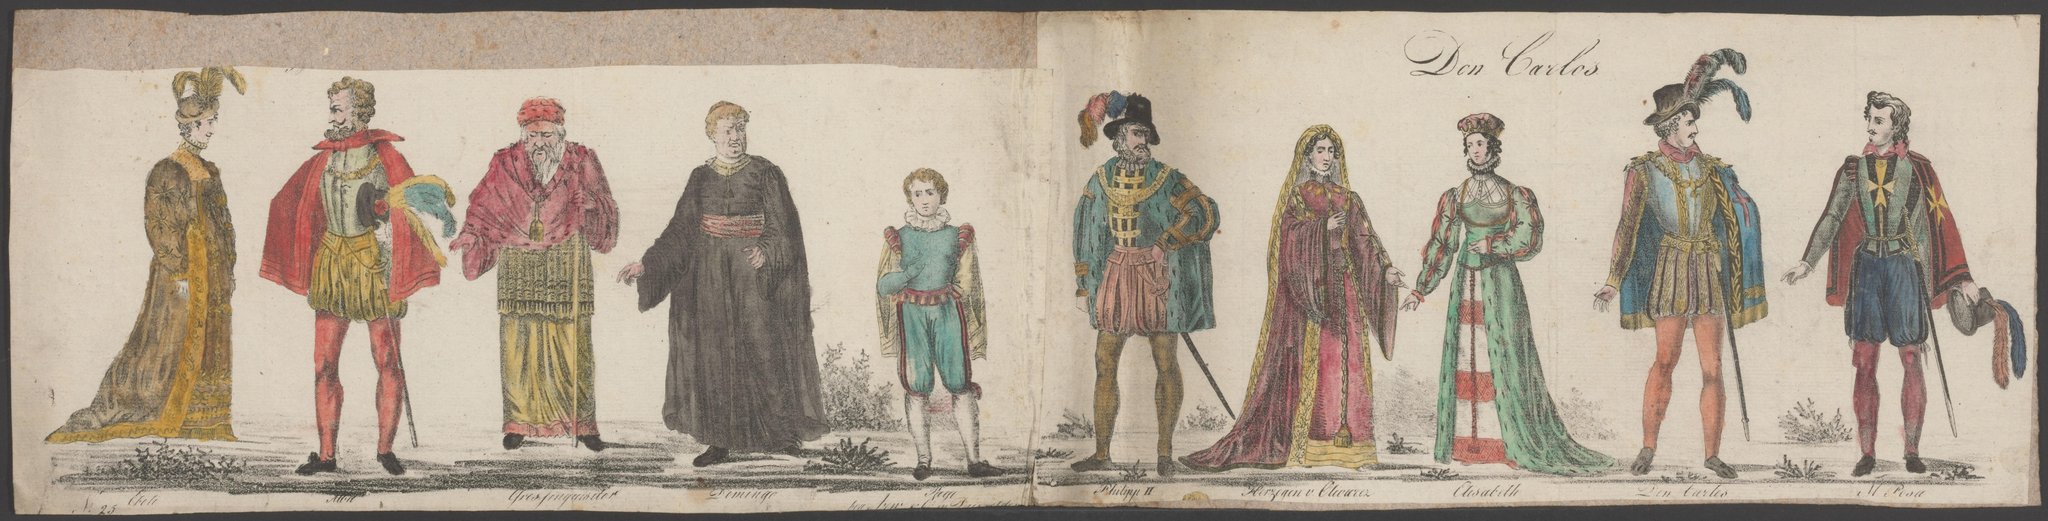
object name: print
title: Don Carlos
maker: Anonymous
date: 1800-1899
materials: paper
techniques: hand coloring, lithograph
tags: stage costume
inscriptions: stamp, collector's mark: Lugt 1641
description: Onderwerpsrubrieken binnen de Atlas Zeden en Gewoonten: Zeden en gewoonten in engeren zin, Des menschen begin, midden en einde, Kinderprenten opgeplakt op karton.